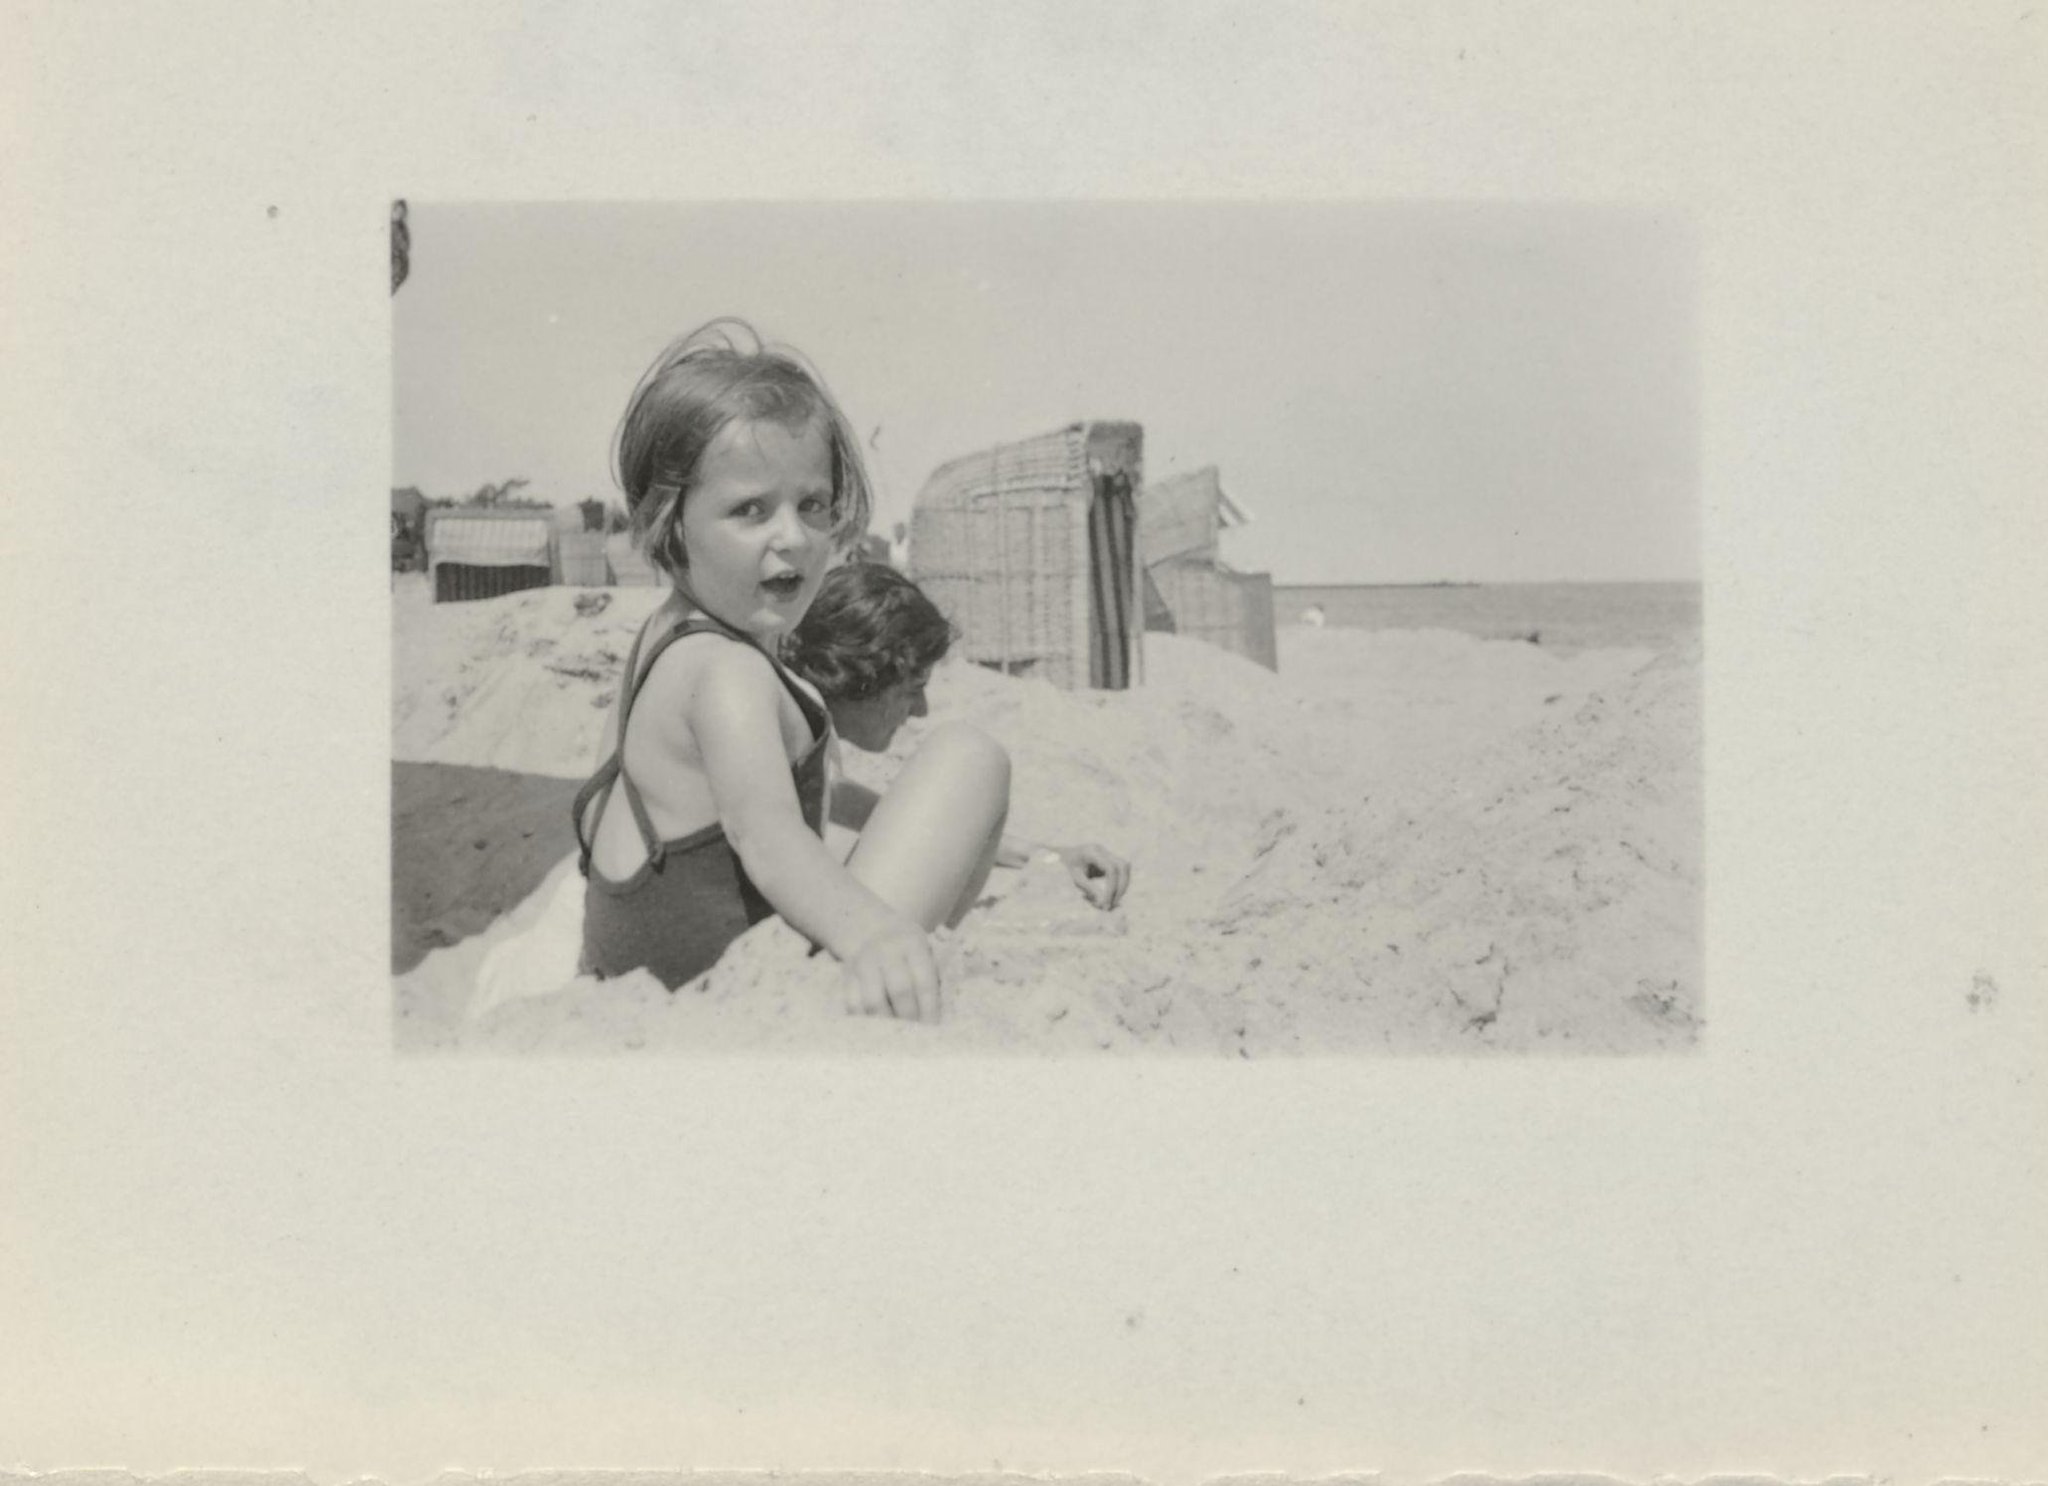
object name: photograph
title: Isabel Wachenheimer op strand van Travemünde, augustus 1933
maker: Anonymous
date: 1908-1933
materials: photographic support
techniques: gelatin silver print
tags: leiden, isabel wachenheimer-elon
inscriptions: date: ‘Aug.33. Travemünde’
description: Dit object is onderdeel van de nalatenschap van Isabel Elon-Wachenheimer (1928-2010). Tot haar overlijden behoorde het samen met de andere objecten uit de nalatenschap tot haar privédomein van Isabel Wachenheimer. In die particuliere context zijn deze objecten tezamen en individueel aandenkens - aan de jeugd, ouders en familie van Isabel Wachenheimer vóór en tijdens de Shoah en aan haar leven na de Tweede Wereldoorlog. Isabel Wachenheimer, die van juni 1943 tot mei 1945 gevangen zat in Kamp Westerbork, Theresienstadt, Auschwitz, Lenzing a/d Oberdonau (een buitenkamp van Mauthausen), overleefde de Shoah. Haar ouders – Eugène Wachenheimer en Else Wachenheimer-Moos - werden op 14 oktober 1944 in Auschwitz-Birkenau vermoord.